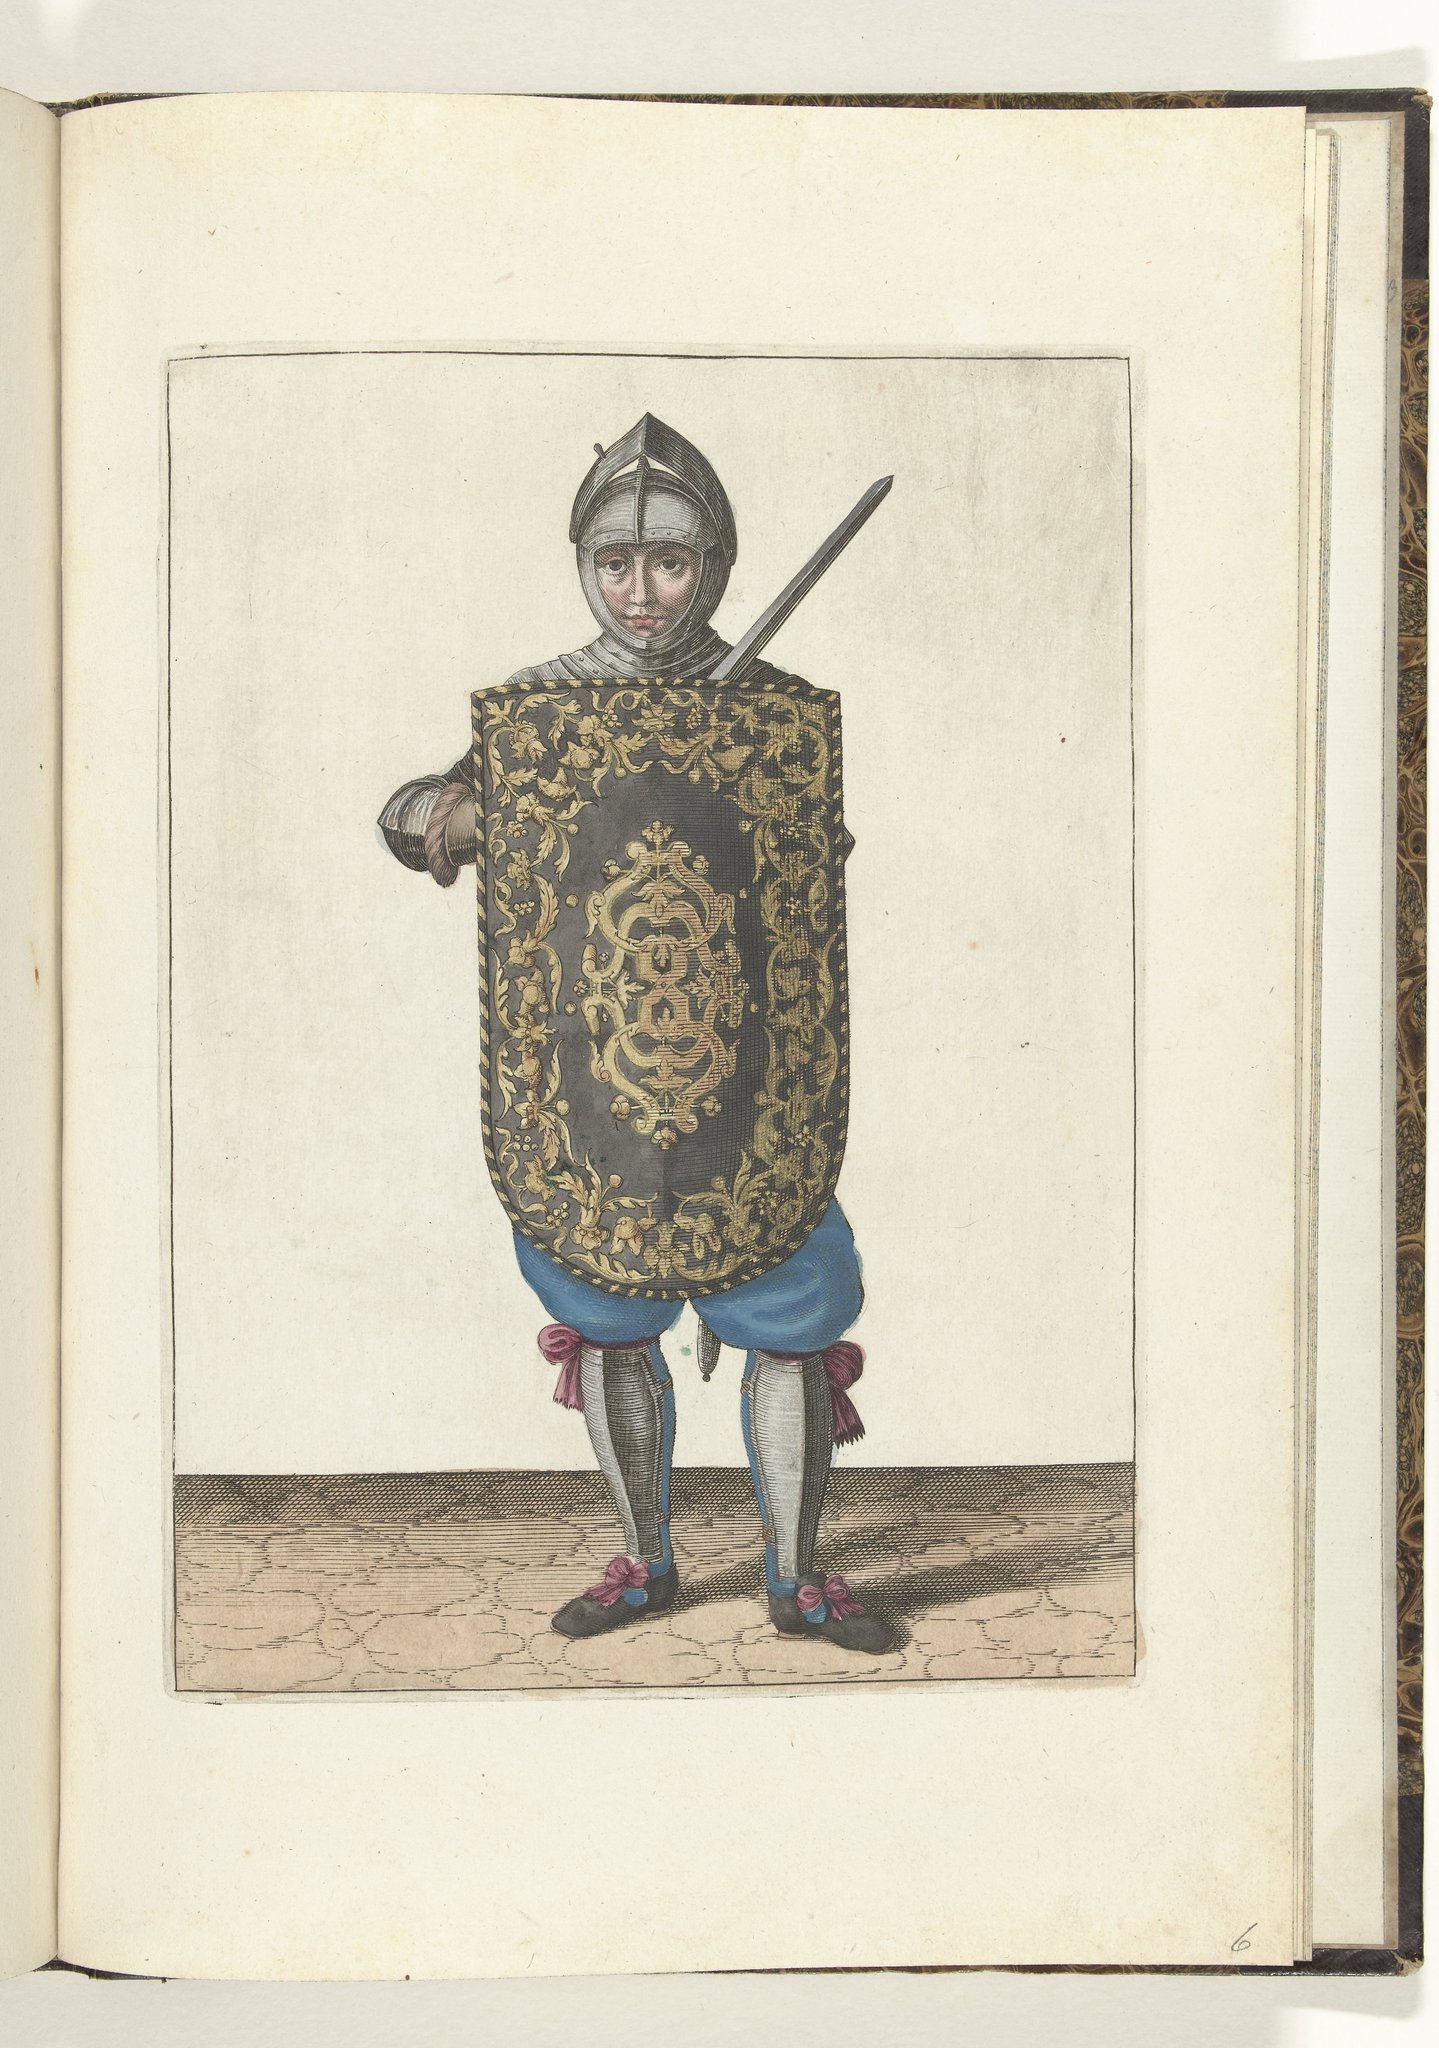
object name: print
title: De exercitie met de targe en rapier: de soldaat houdt de targe voor de borst en de getrokken rapier tegen de linkerschouder (nr. 6), 1618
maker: Anonymous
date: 1616-1618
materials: paper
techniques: engraving, hand coloring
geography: northern netherlands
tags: maurice (prince of orange), handling of weapons ~ military training, weapons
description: Illustratie in: Adam van Breen, Nassauische Waffenhandelung / Kurtzer Bericht unnd Ahnzeigungh auff die Ab-bildungh der Figuren / den rechten brauch alles des jenigen betreffend / so einem Soldaten von nöten / in der handlung der Targa, met dem Degen [incompleet exemplaar], 1618?, plaat [6]. Dit is een Duitse editie van Adam van Breens De Nassausche Wapen-Handelinge, van Schilt, Spies, Rappier ende Targe : beyde figuerlick afgebeelt, ende gestelt na de nieu ordening [van] ... Maurits van Nassau, 's-Gravenhage, [Aert Meuris] 1618. In het exemplaar in de collectie van de Rijksmuseum Research Library (326 F 23).